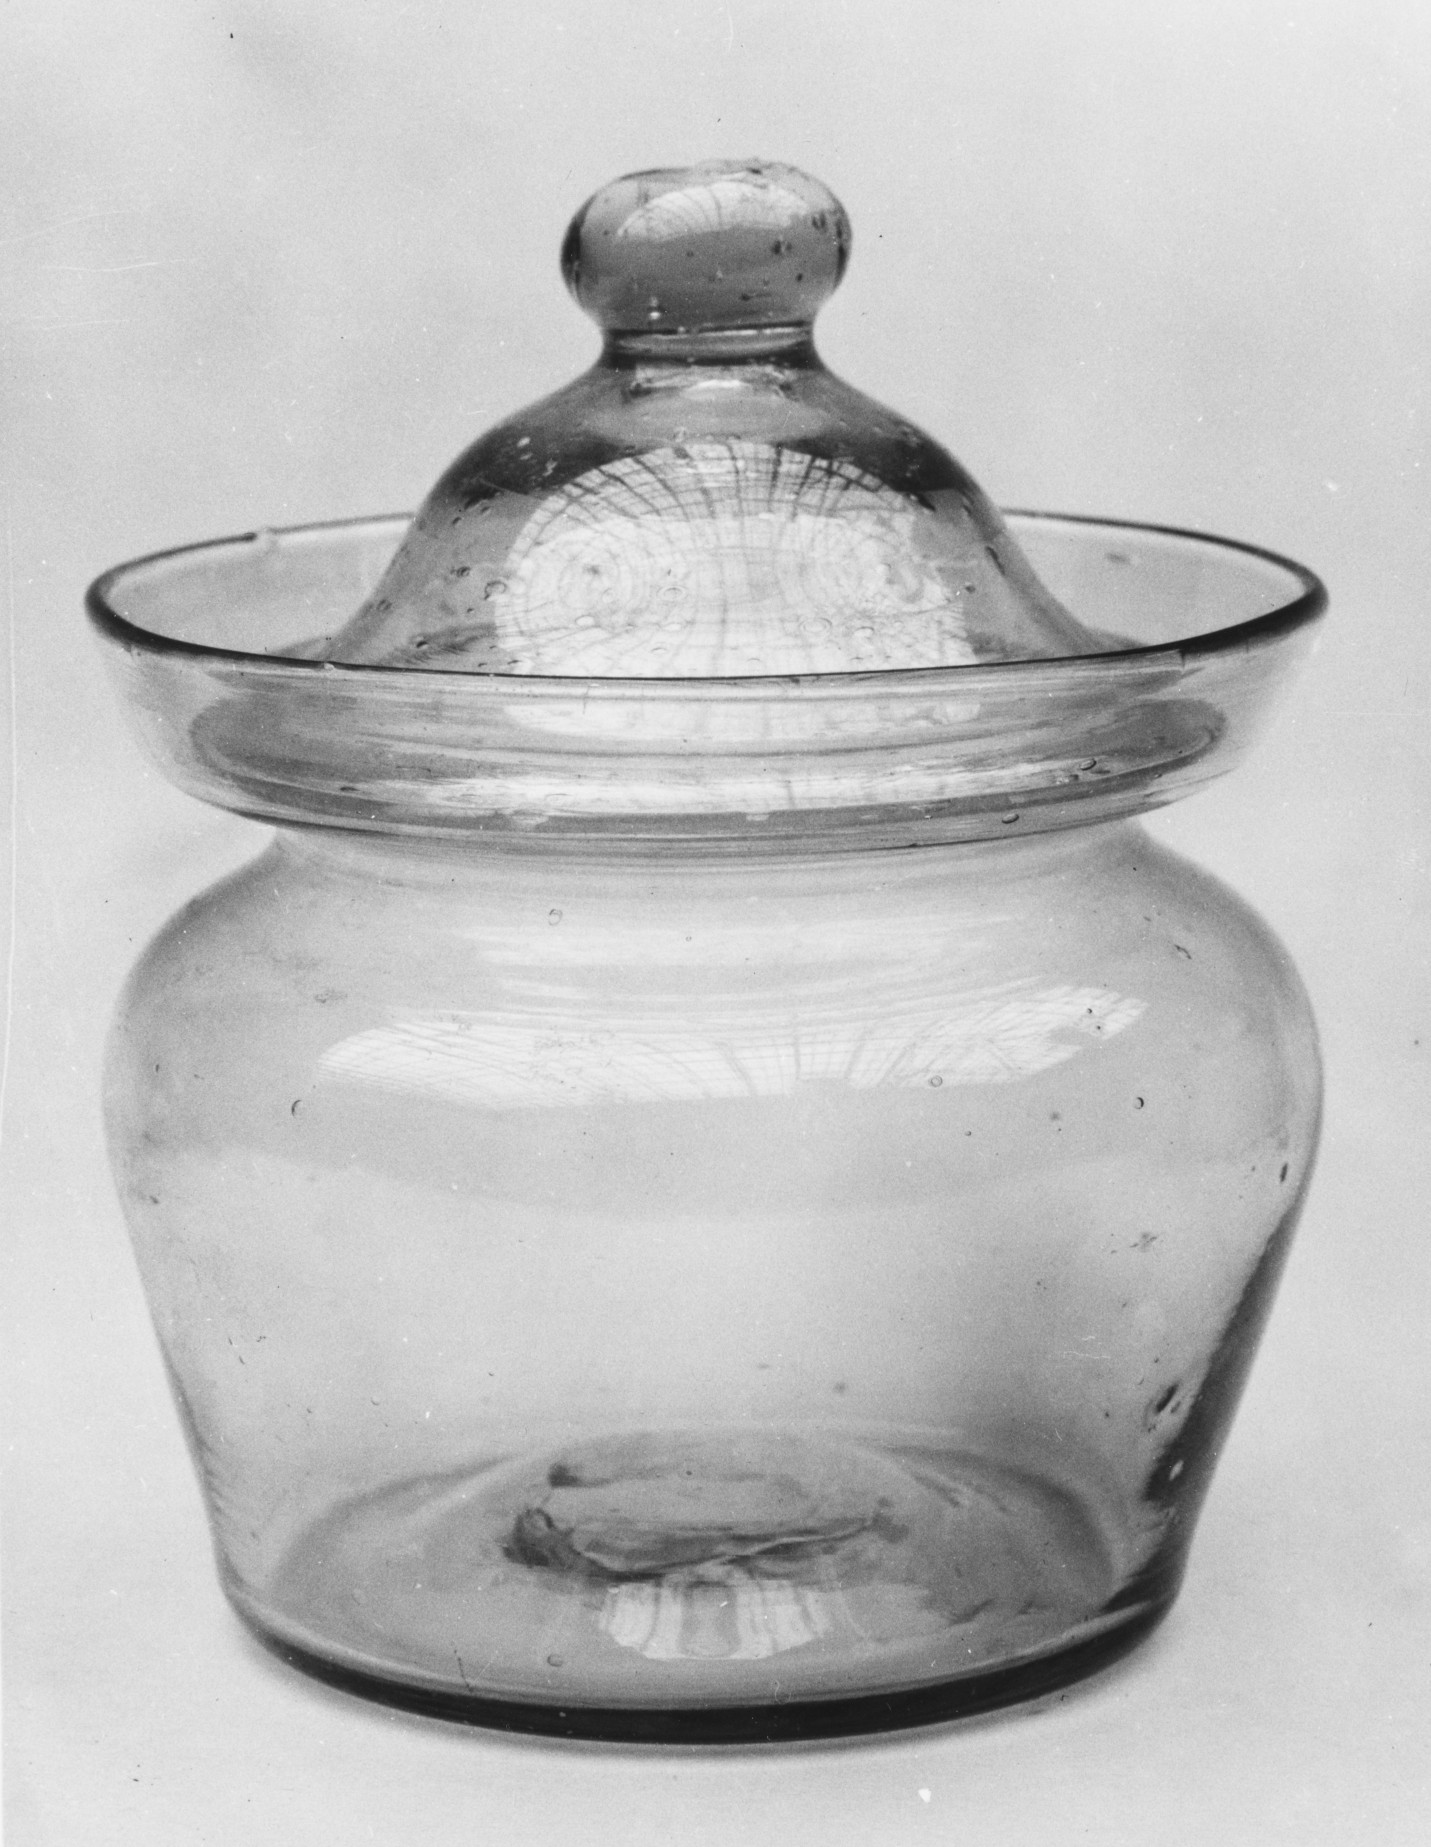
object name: bowl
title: Covered Bowl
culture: american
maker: charles a. cornwall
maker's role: designer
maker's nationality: american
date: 1833-1868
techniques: glassblowing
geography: united states